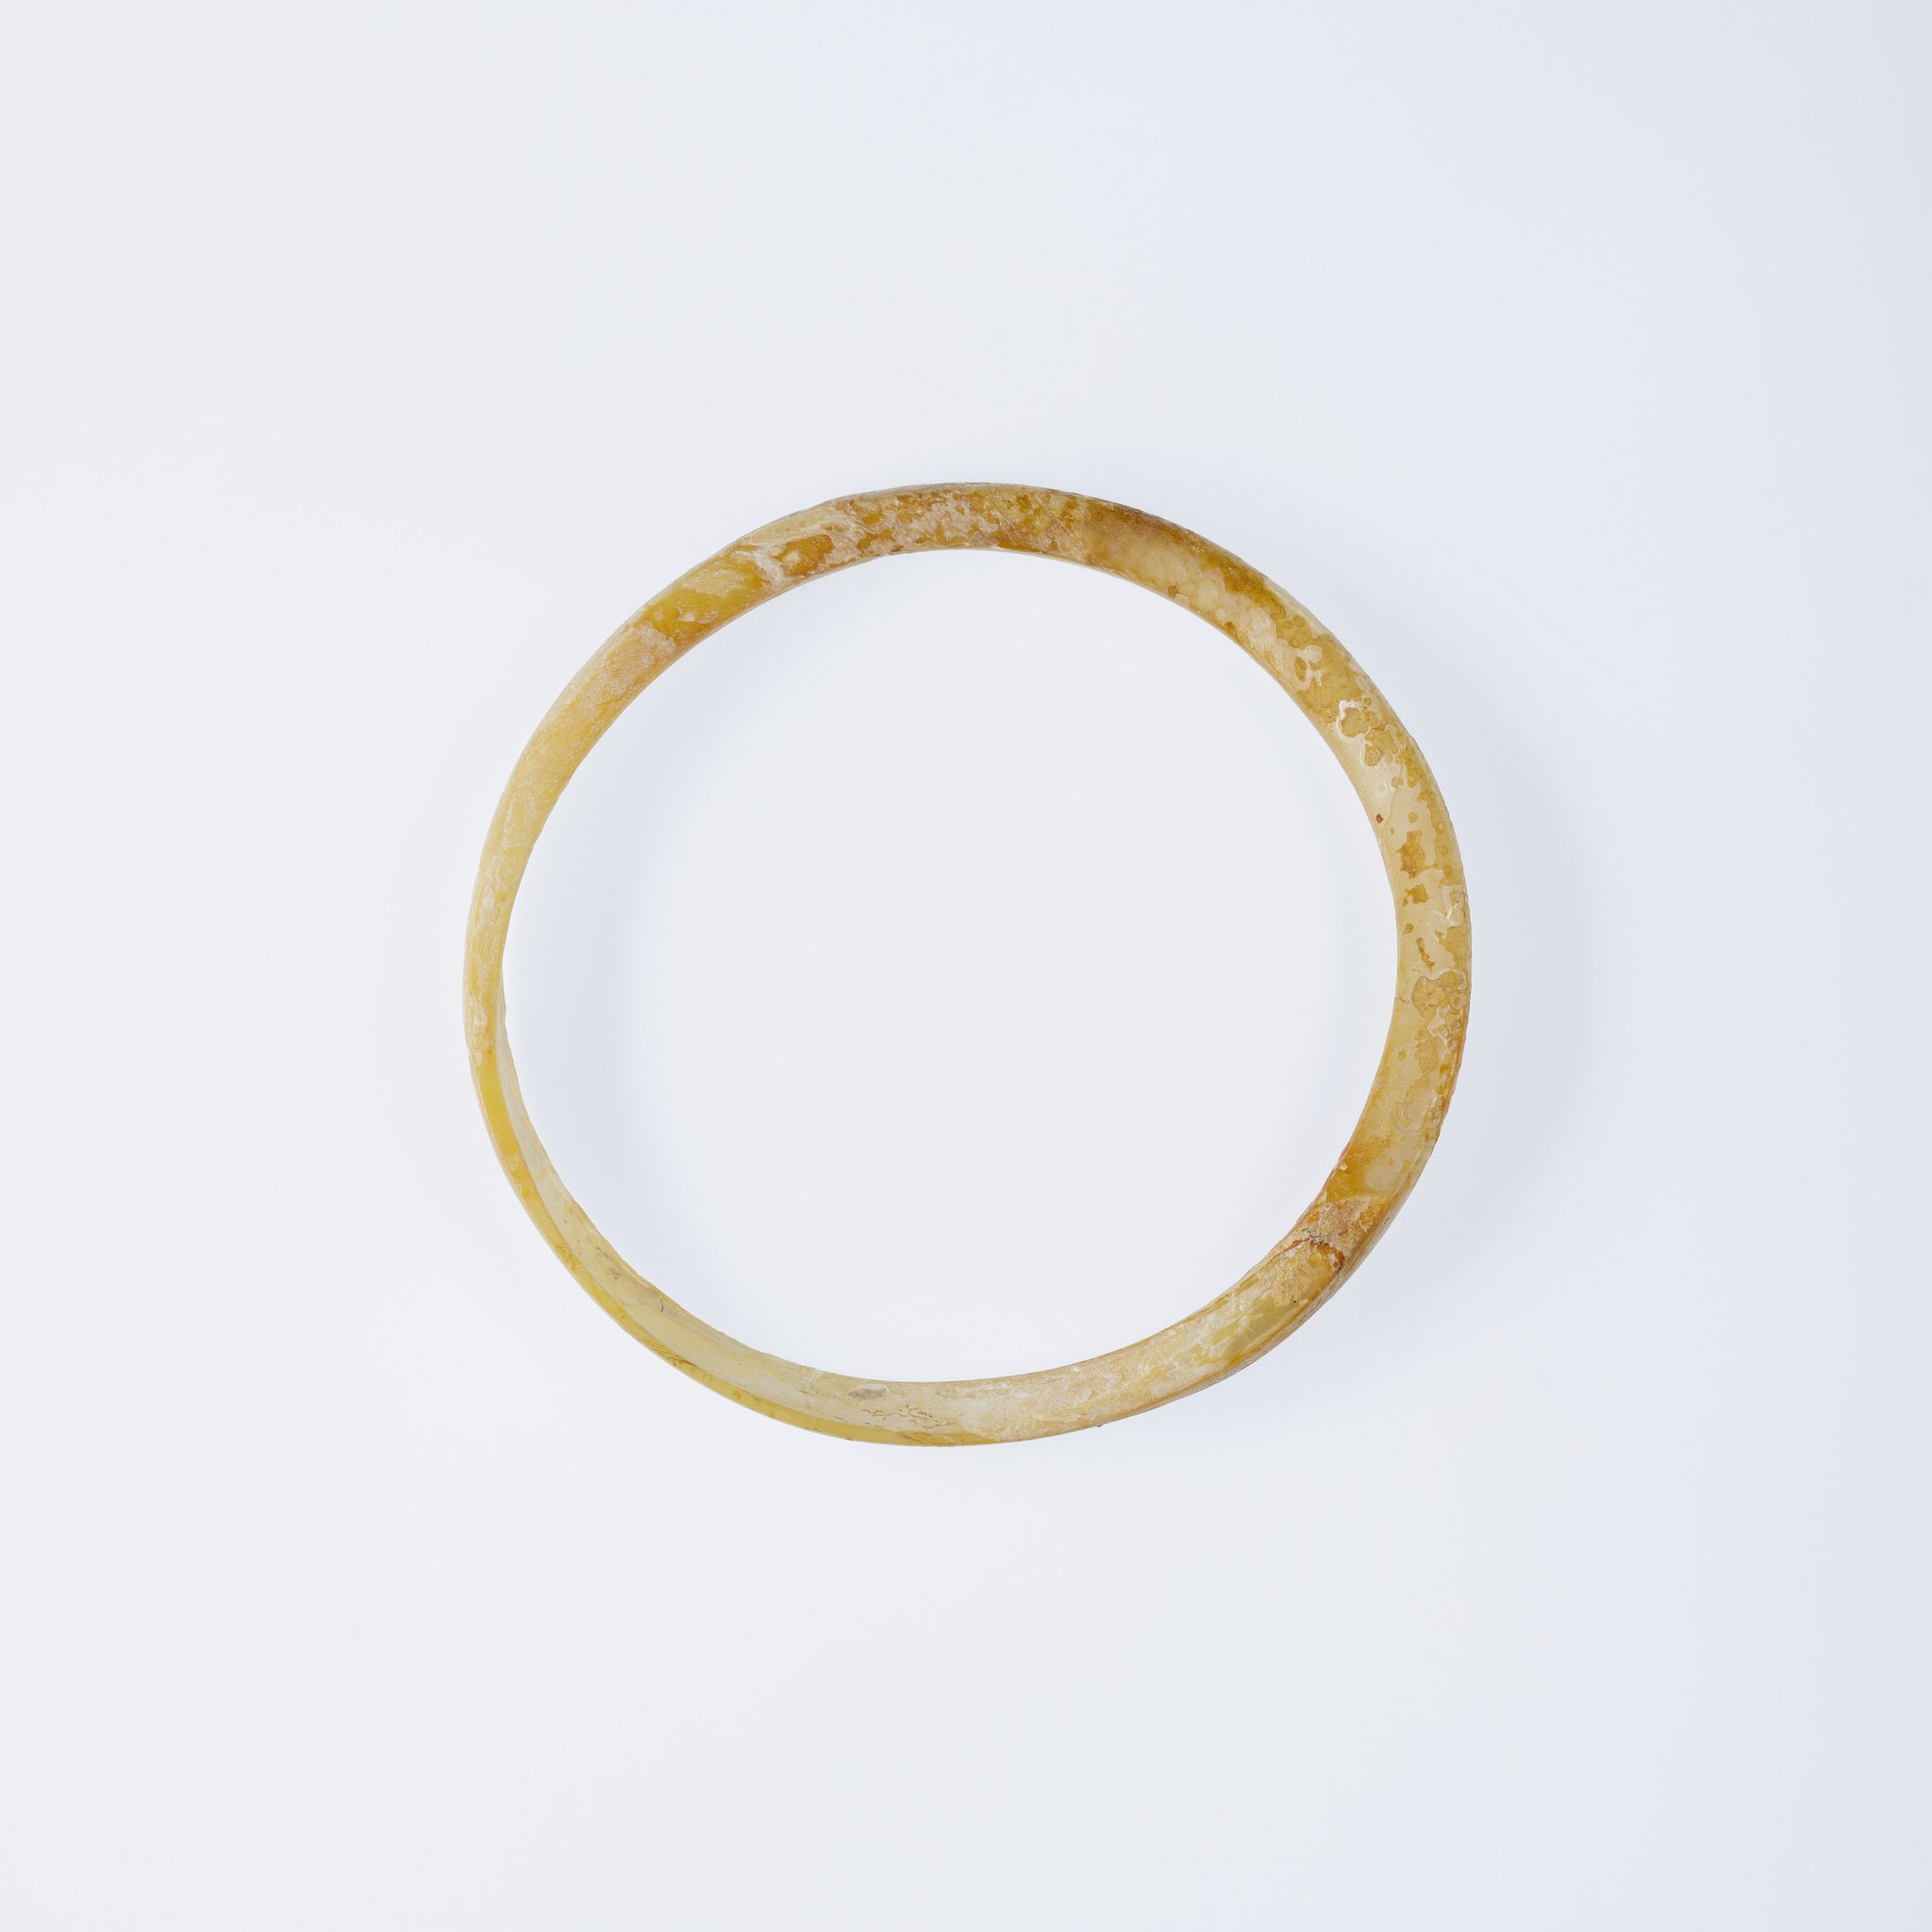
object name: bracelet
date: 2960-2649 BCE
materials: shell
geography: egypt